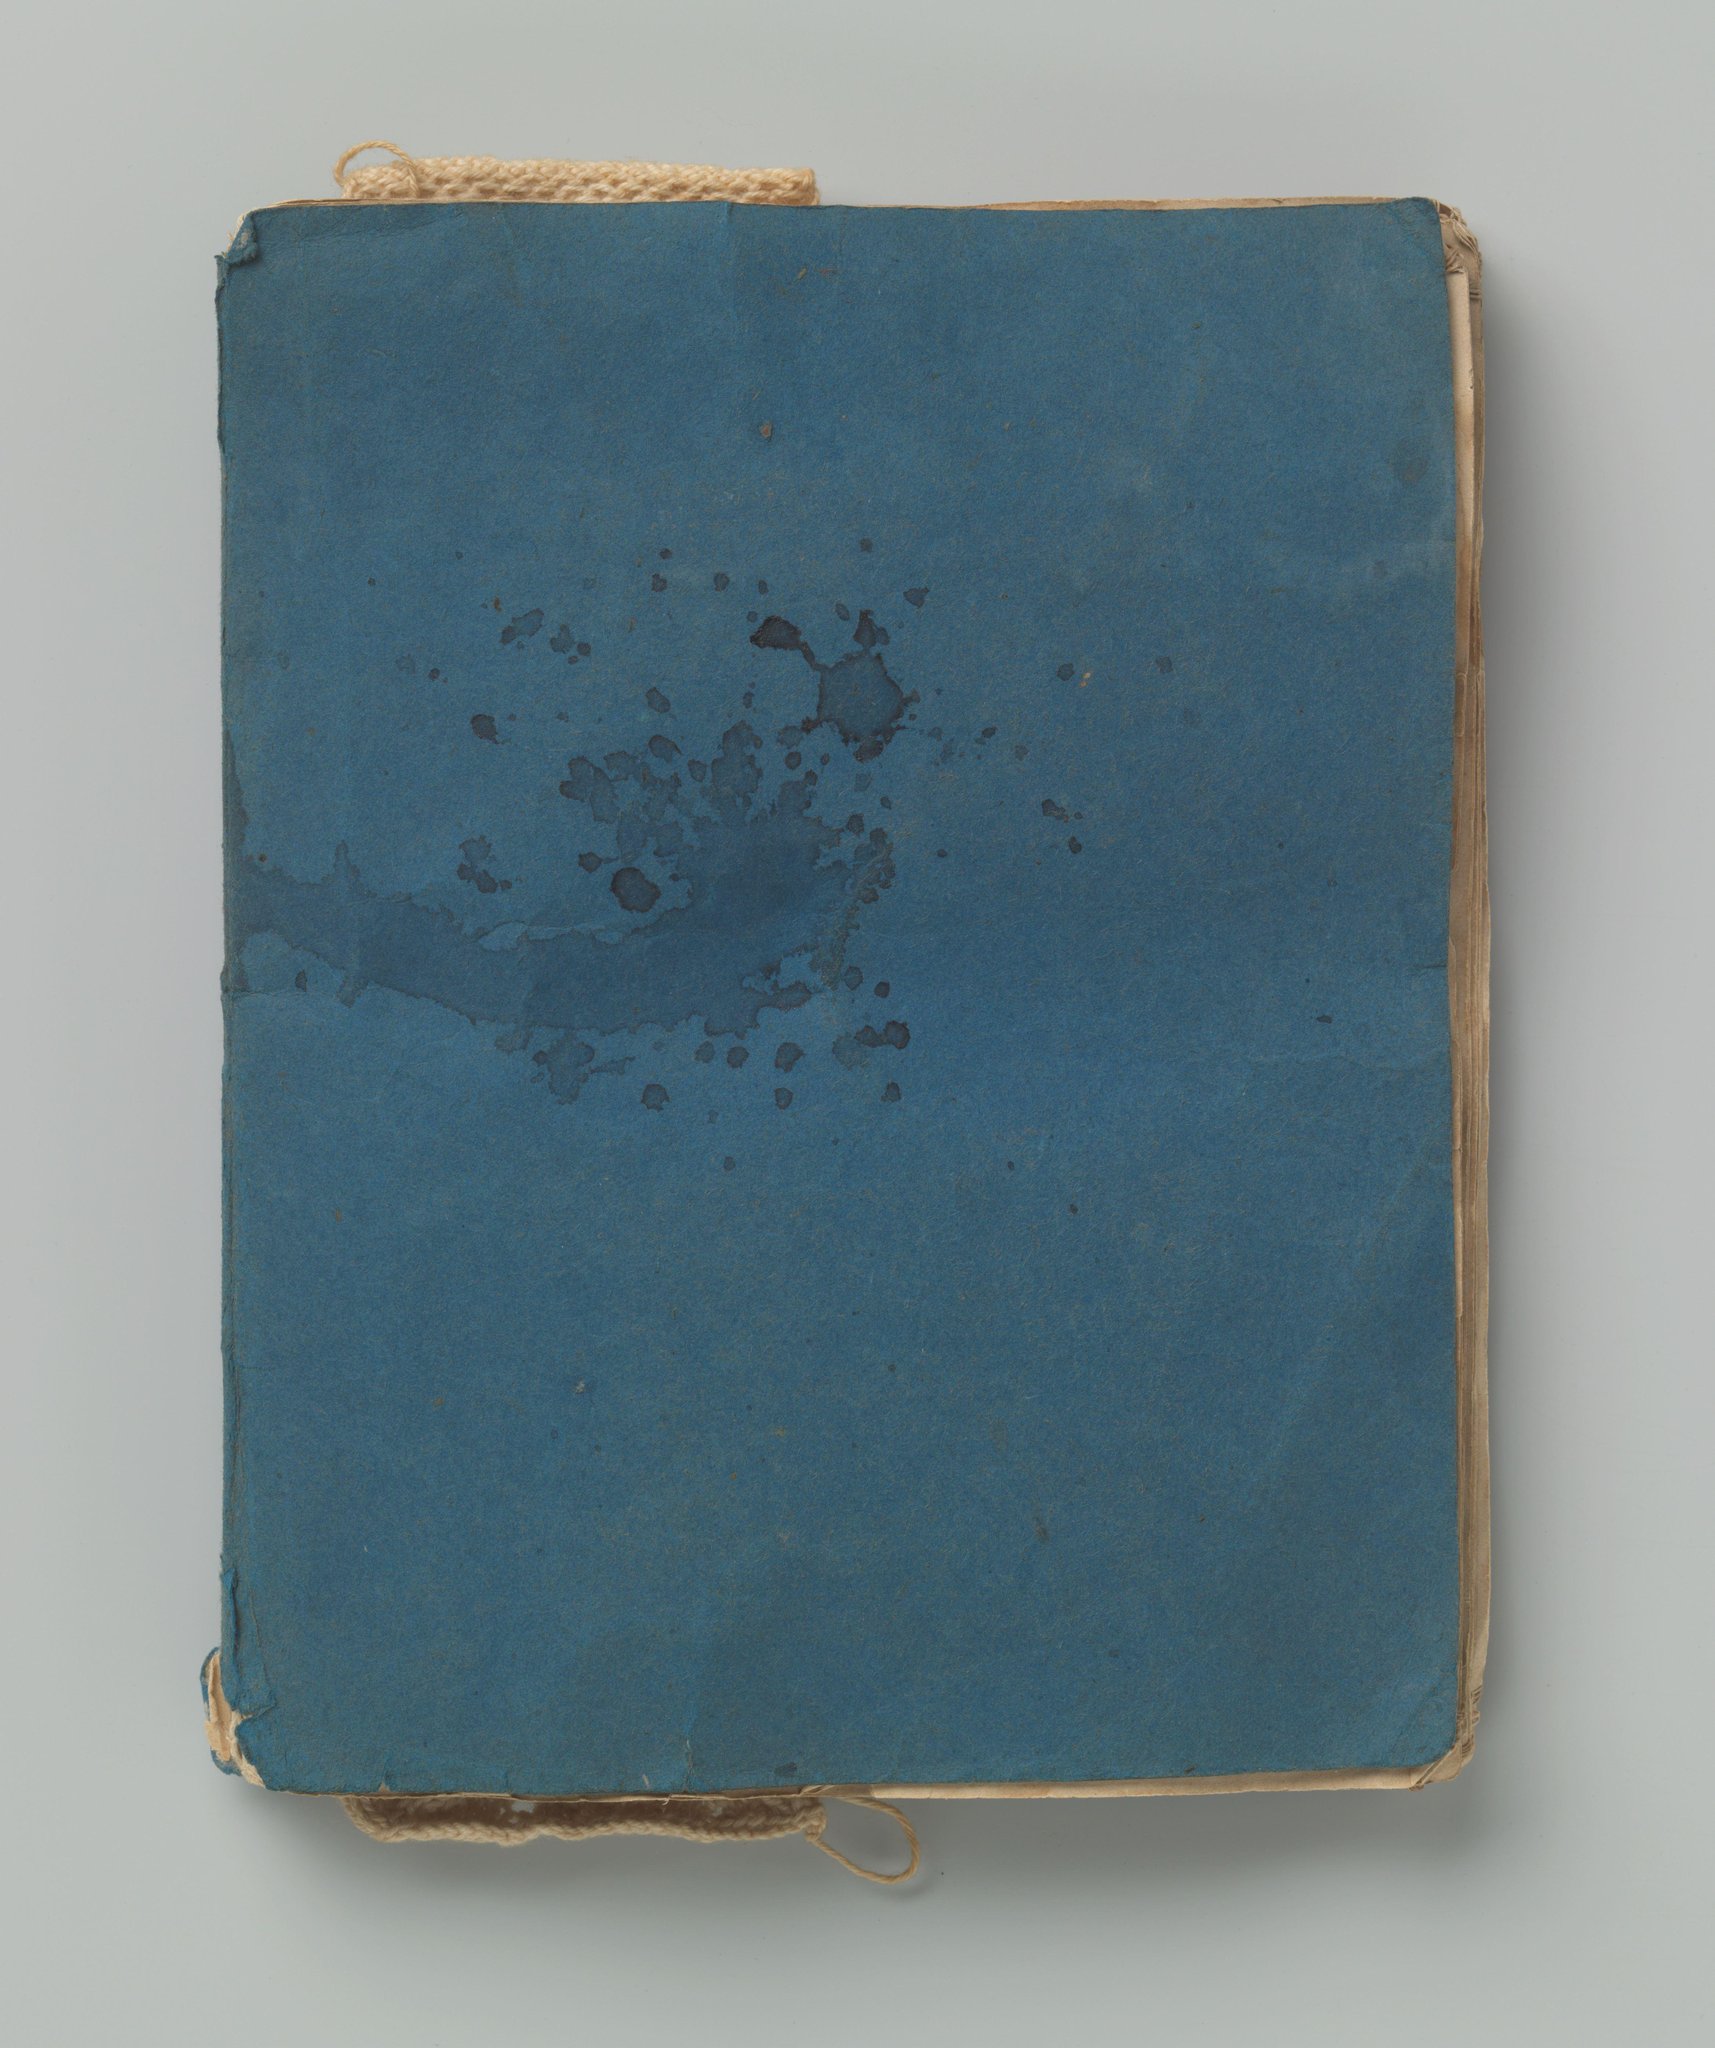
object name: werkstuk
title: Schrift met 41 gebreide proeflappen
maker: m.a. smid-alberts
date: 1867-1949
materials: cotton, paper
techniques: knitting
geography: netherlands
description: Schrift met een blauwe omslag waarin 41 proeflappen van gebreide katoen. Op de binnenkant van de omslag staat met inkt geschreven: M. Alberts.